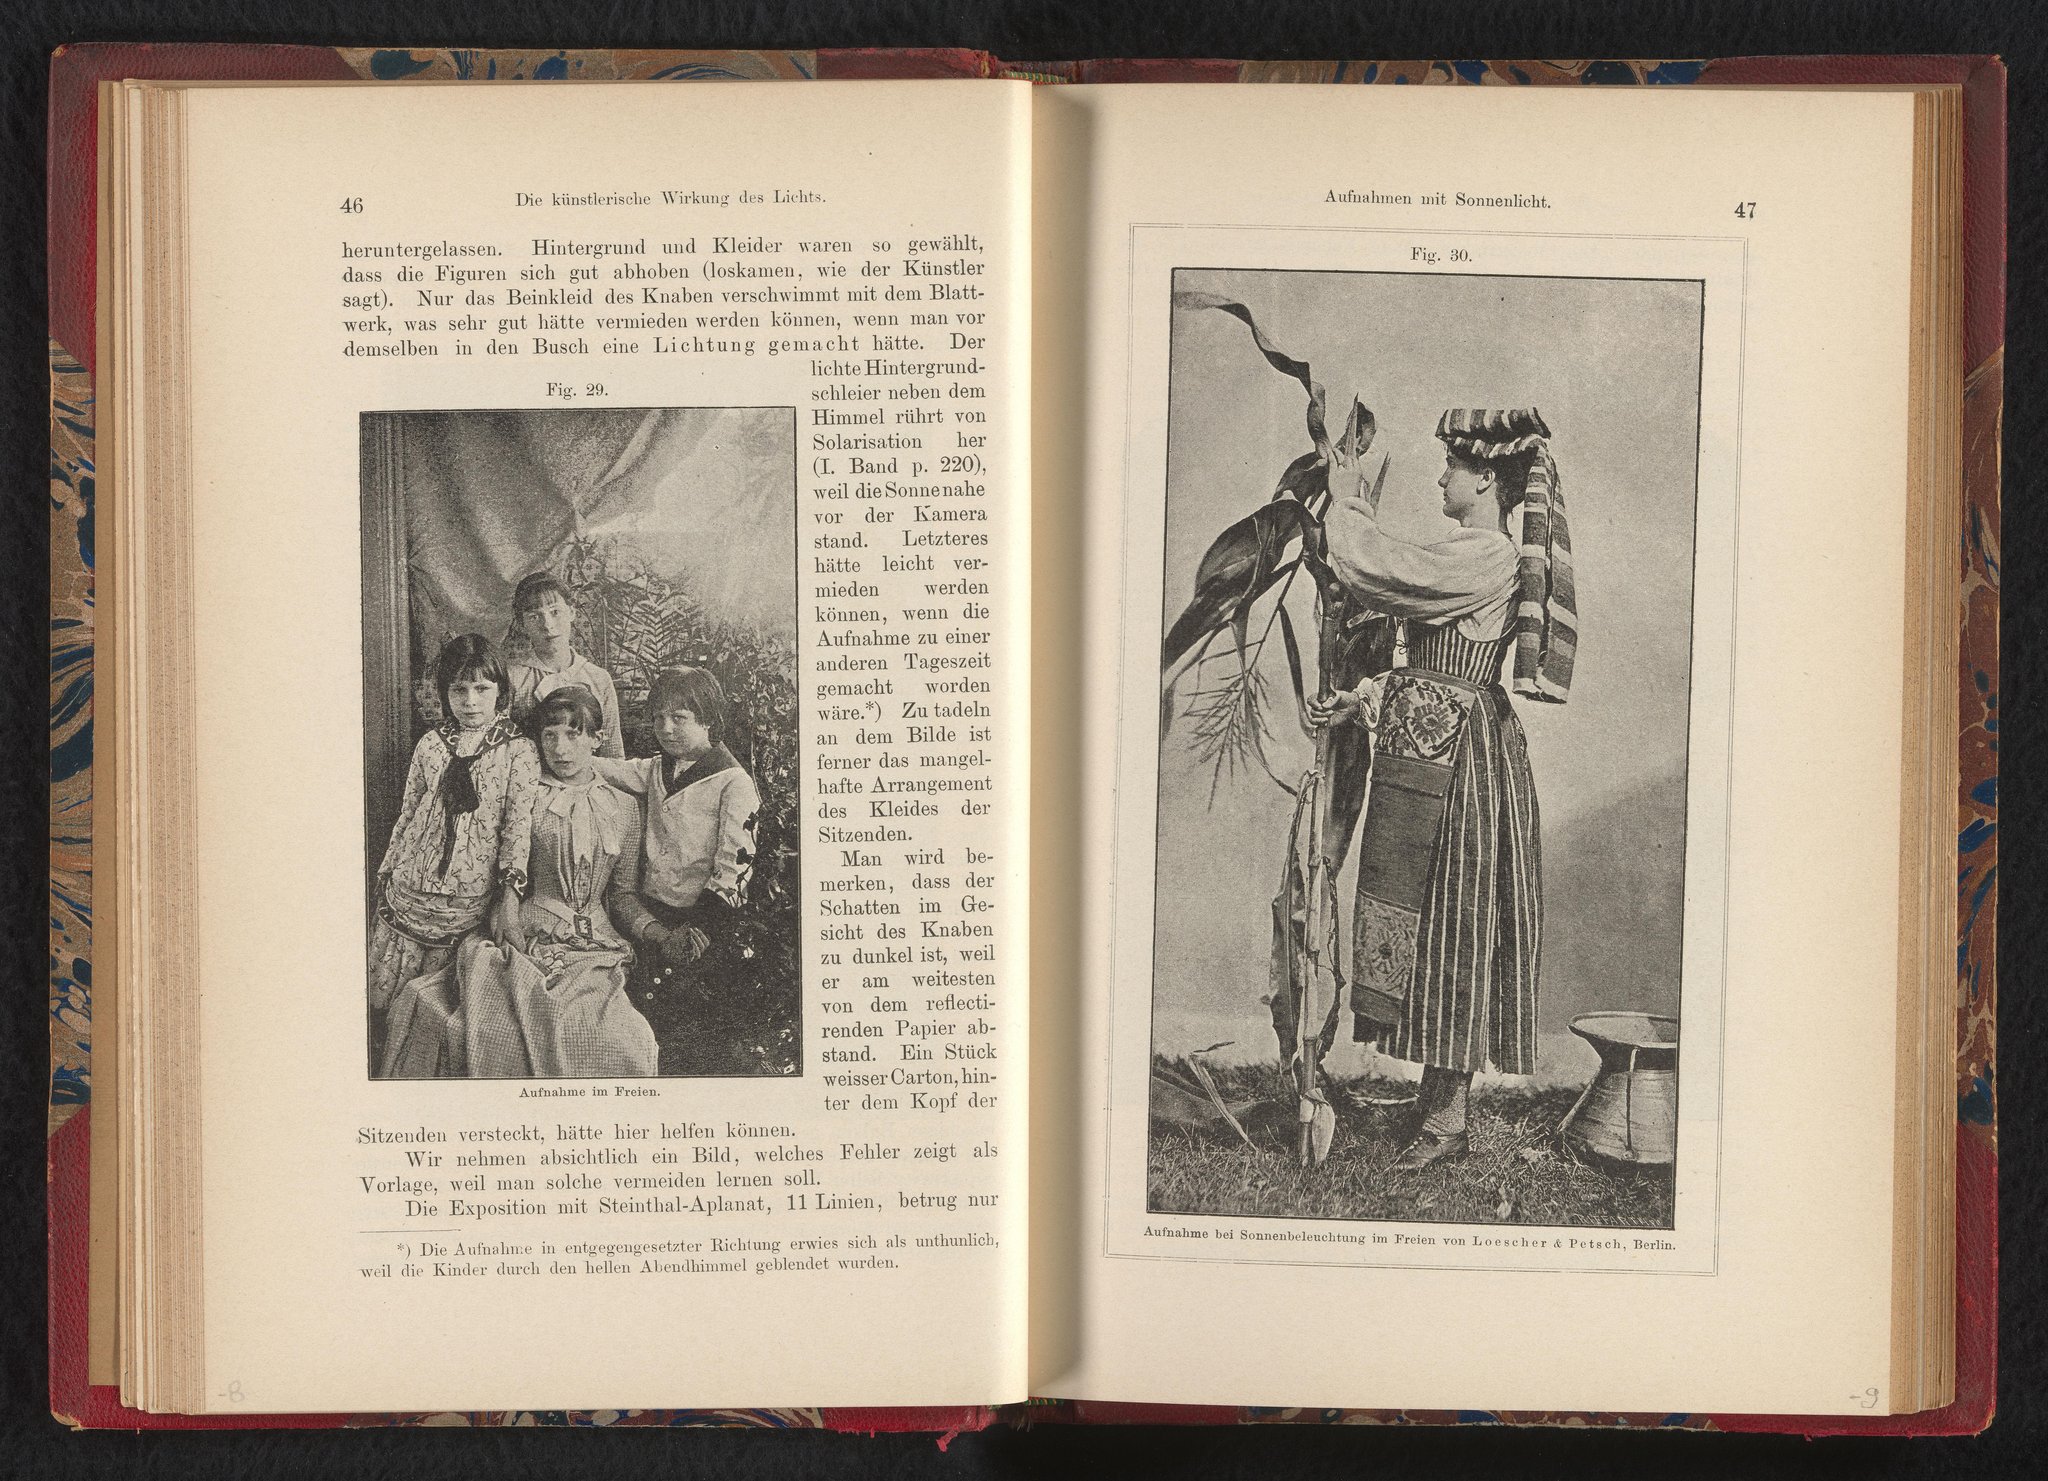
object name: page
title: Portret van een jonge moeder met drie kinderen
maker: Anonymous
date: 1886-1891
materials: paper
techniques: autotype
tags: mother and child(ren), woman and child(ren) (family group)